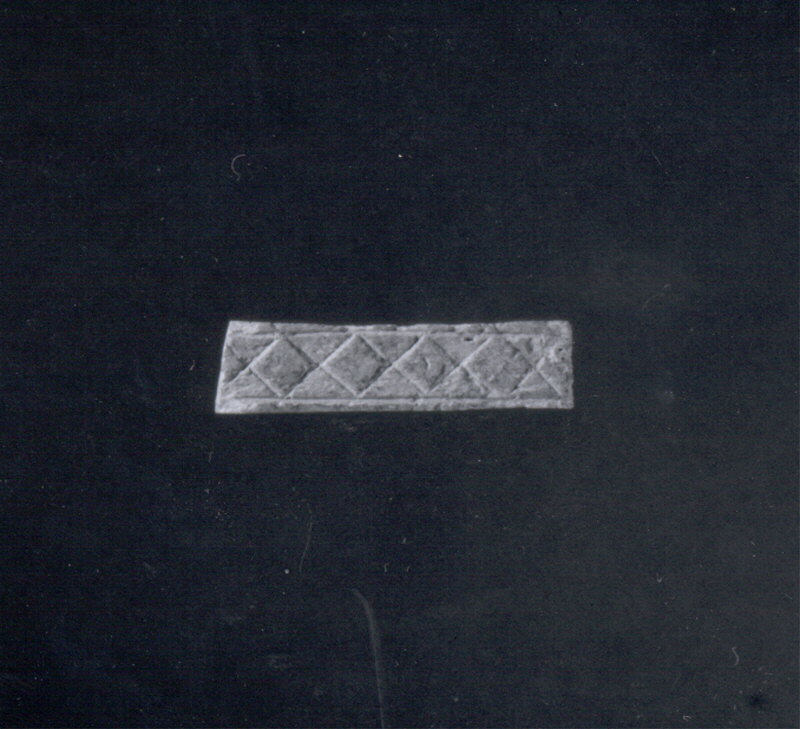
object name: inlay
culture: edomite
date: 700-601 BCE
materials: bone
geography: levant